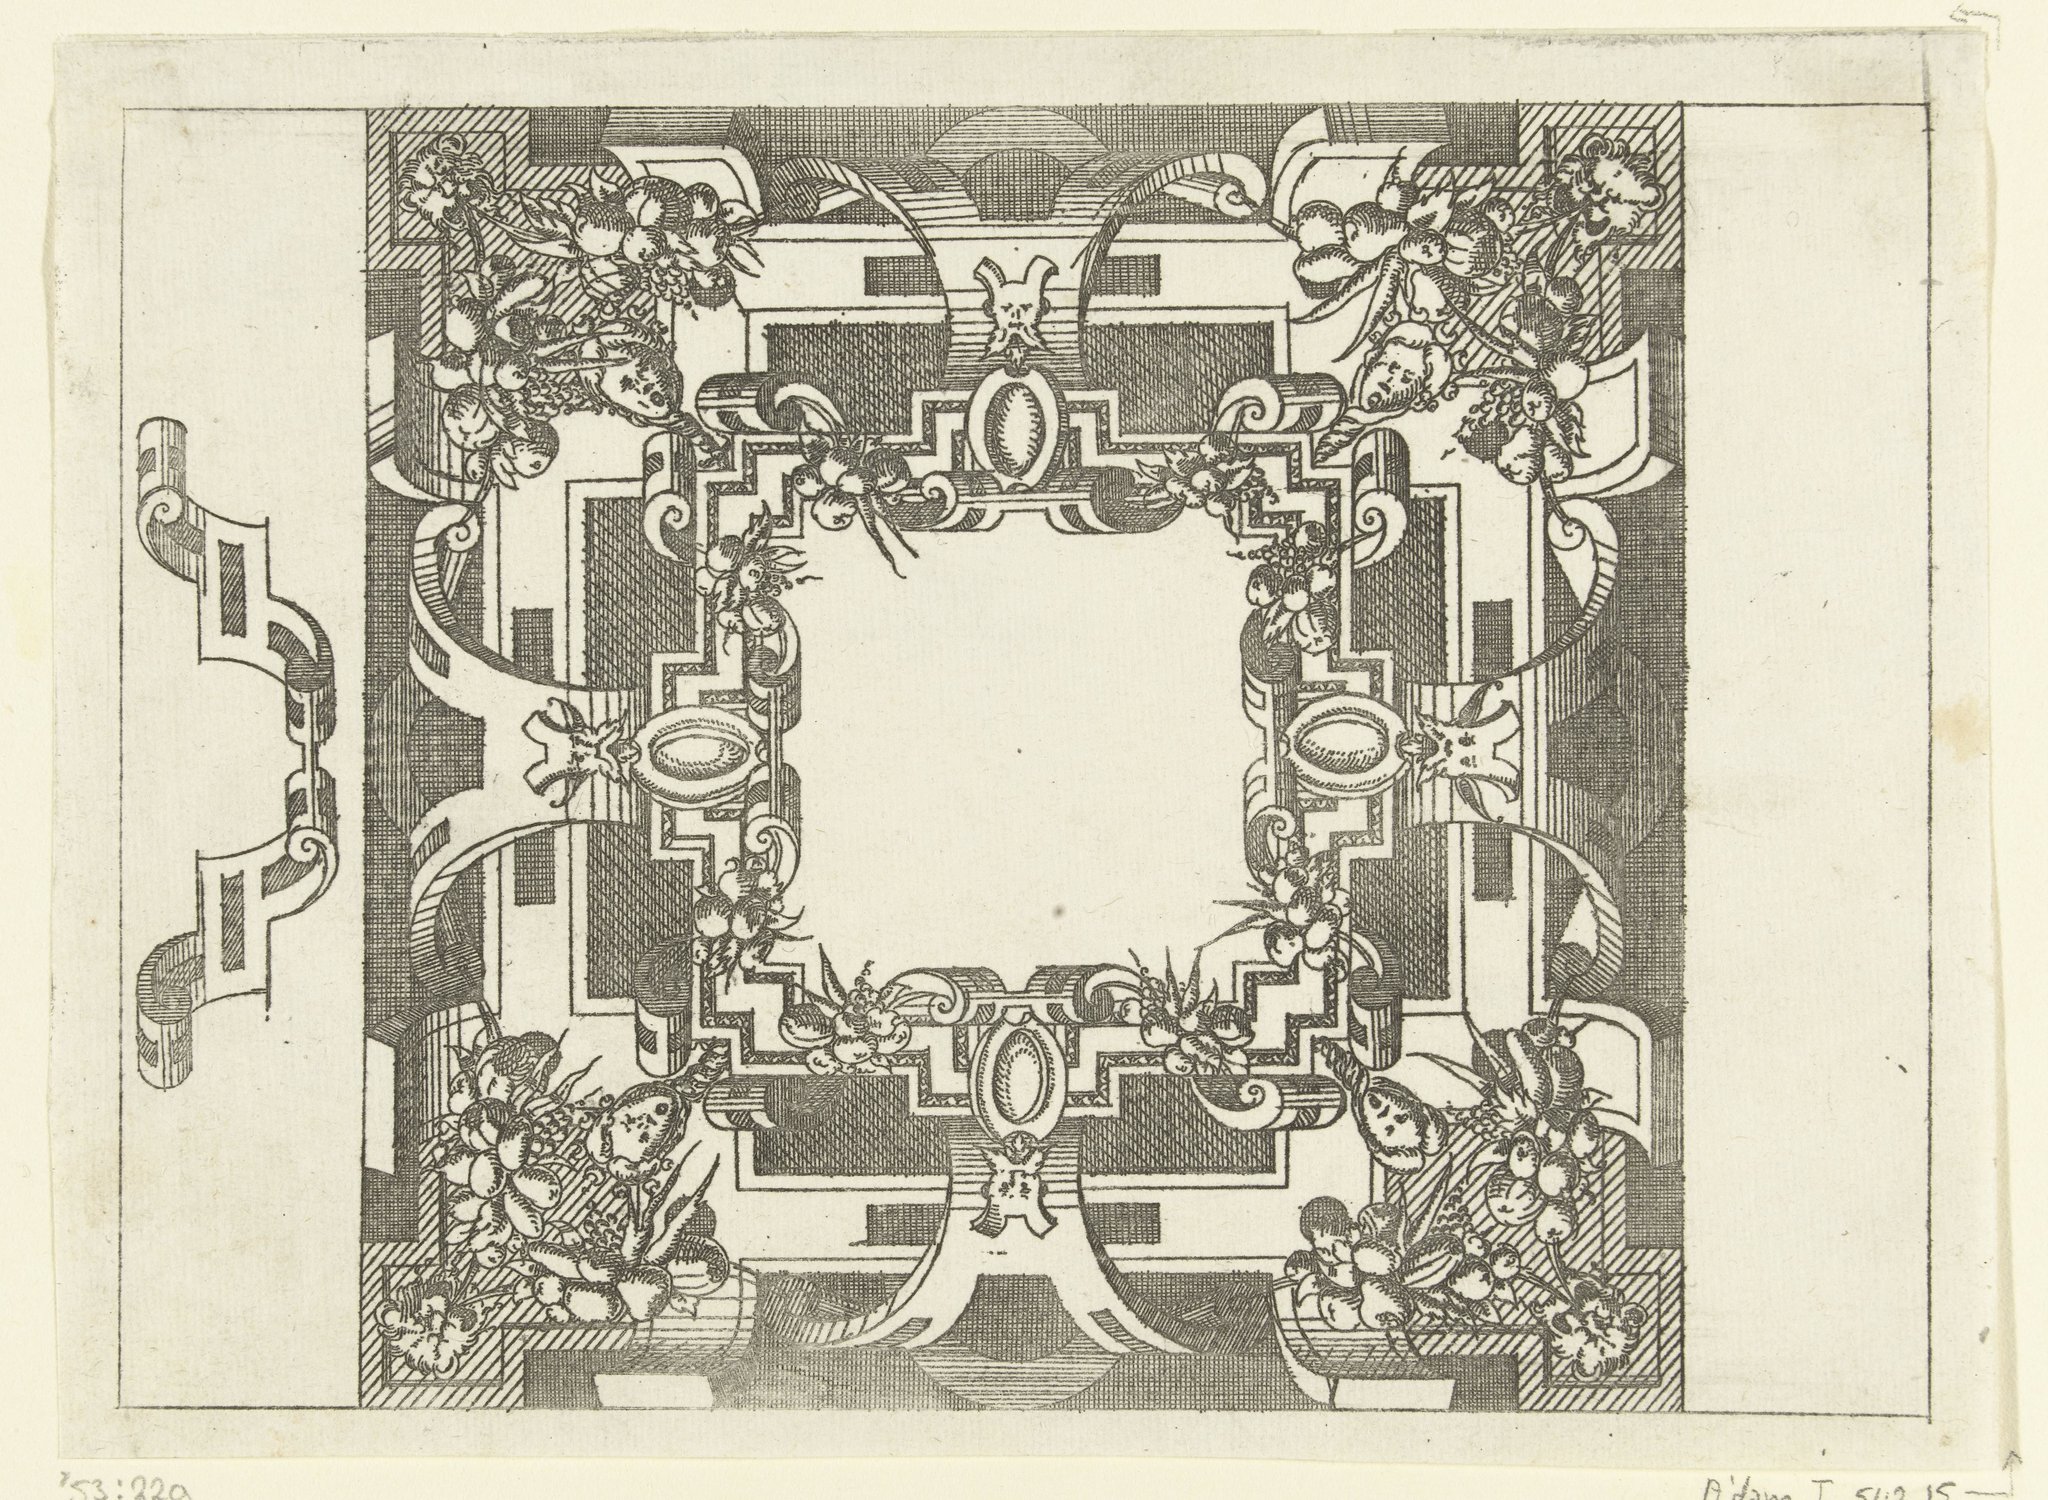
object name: ornament print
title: Plafond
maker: Anonymous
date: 1520-1584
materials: paper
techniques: etching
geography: france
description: Vierkante cartouche in een omlijsting van rolwerk met guirlandes van vruchten. De vier hoeken zijn gedecoreerd met mascarons in de vorm van een leeuwenkop, die de uiteinden van twee guirlandes van vruchten in zijn muil houdt. Uit serie van 32 bladen. De cartouches zijn deels ontleend aan de prenten van Antonio Fantuzzi naar de decoratie van de Galerie van François 1er door Giovanni Battista Rosso. De serie staat ook bekend onder de titel Petits cartouches de Fontainebleau.